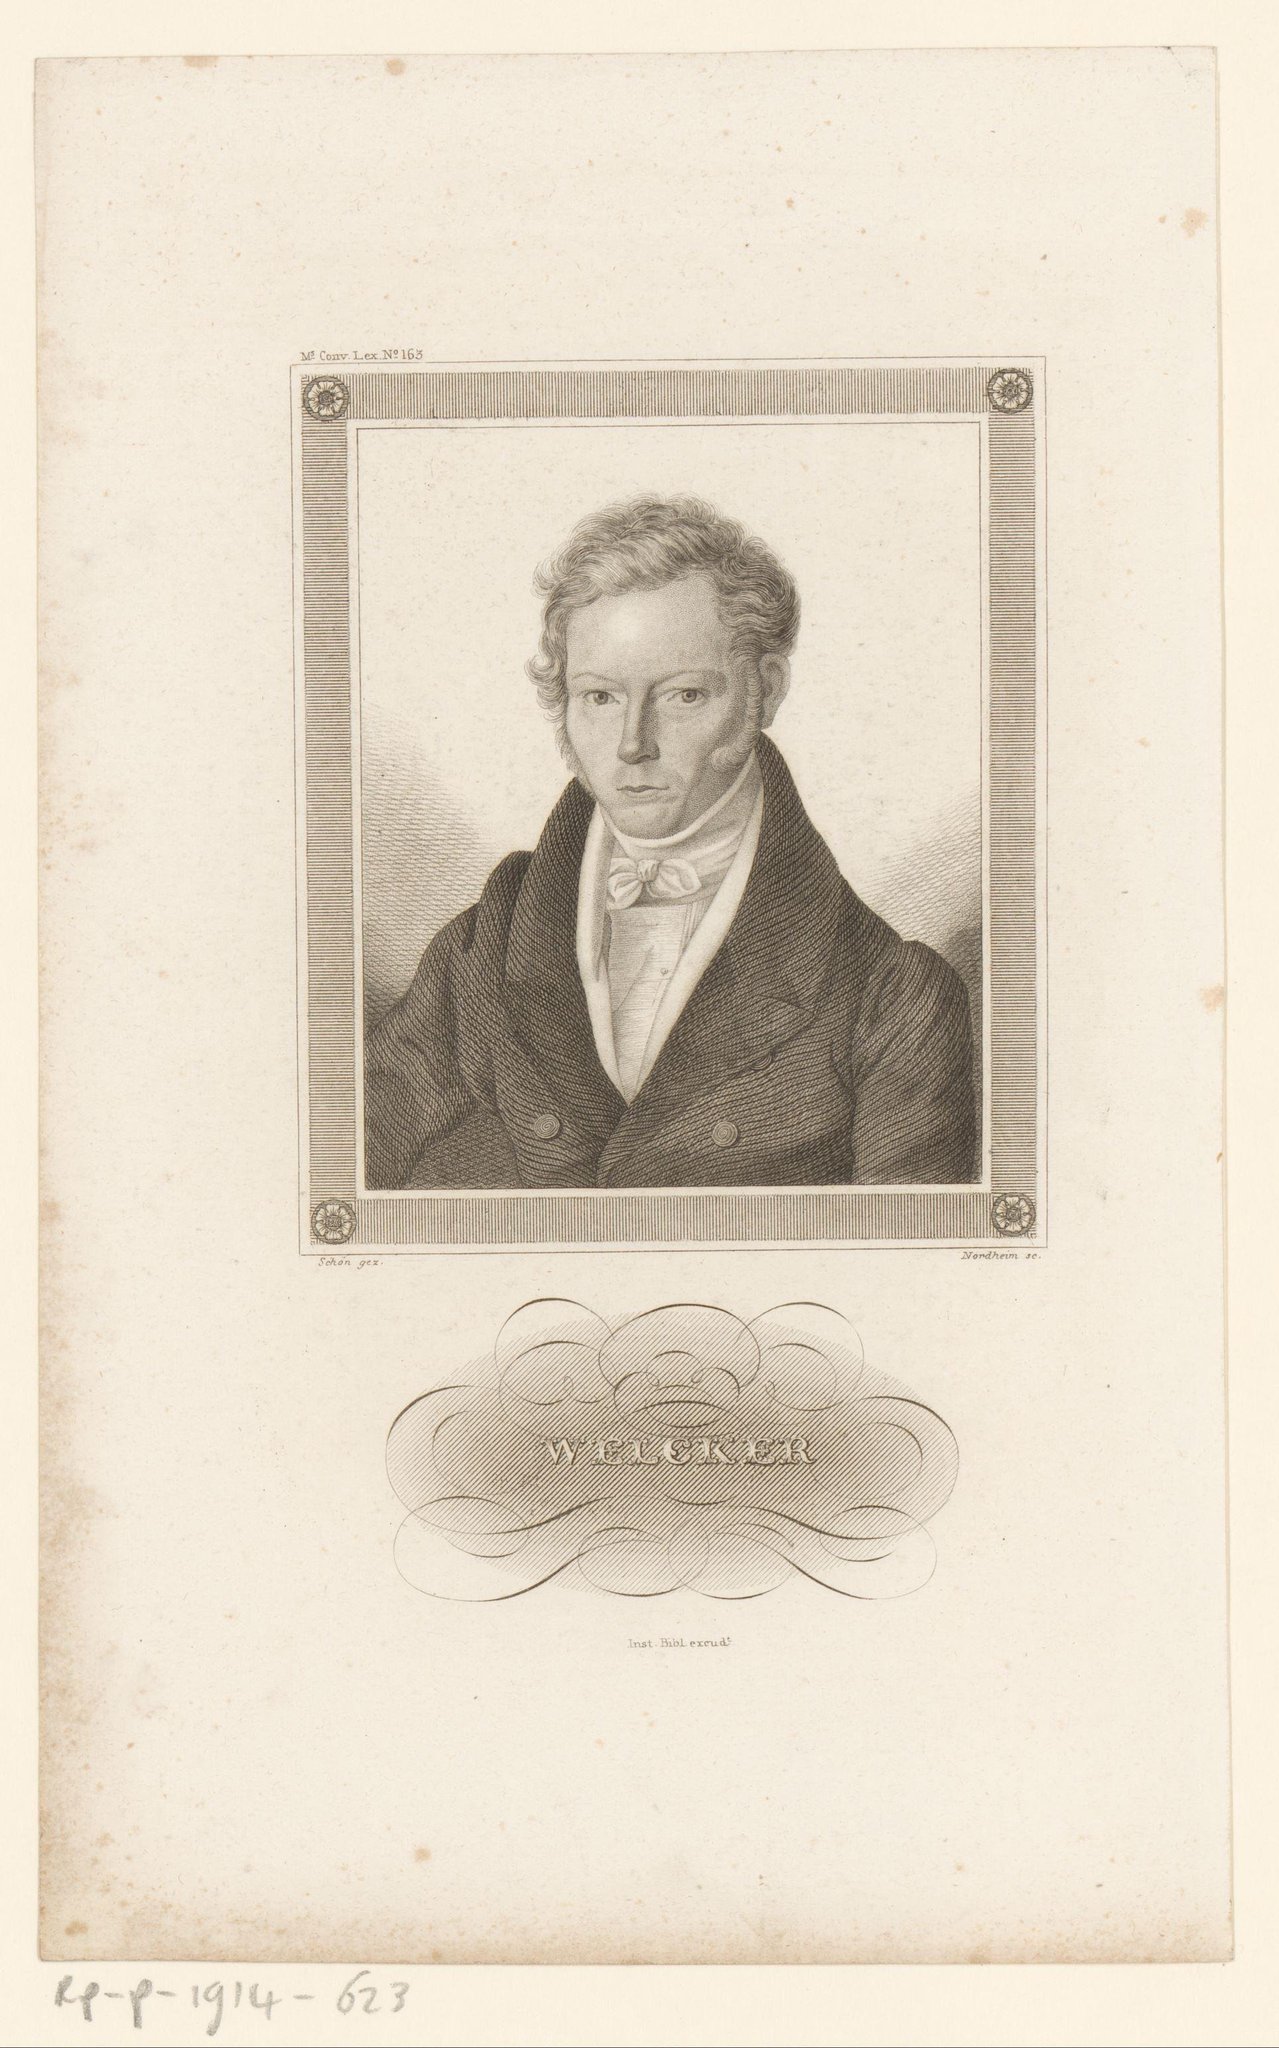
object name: book illustration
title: Portret van Carl Theodor Welcker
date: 1840-1855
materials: paper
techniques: etching, engraving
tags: politician, historical persons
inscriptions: collector's mark: Lugt 2228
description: Prent afkomstig uit: Conversations-Lexikon für die gebildeten Stände, voor het eerst uitgegeven tussen 1840-1855.